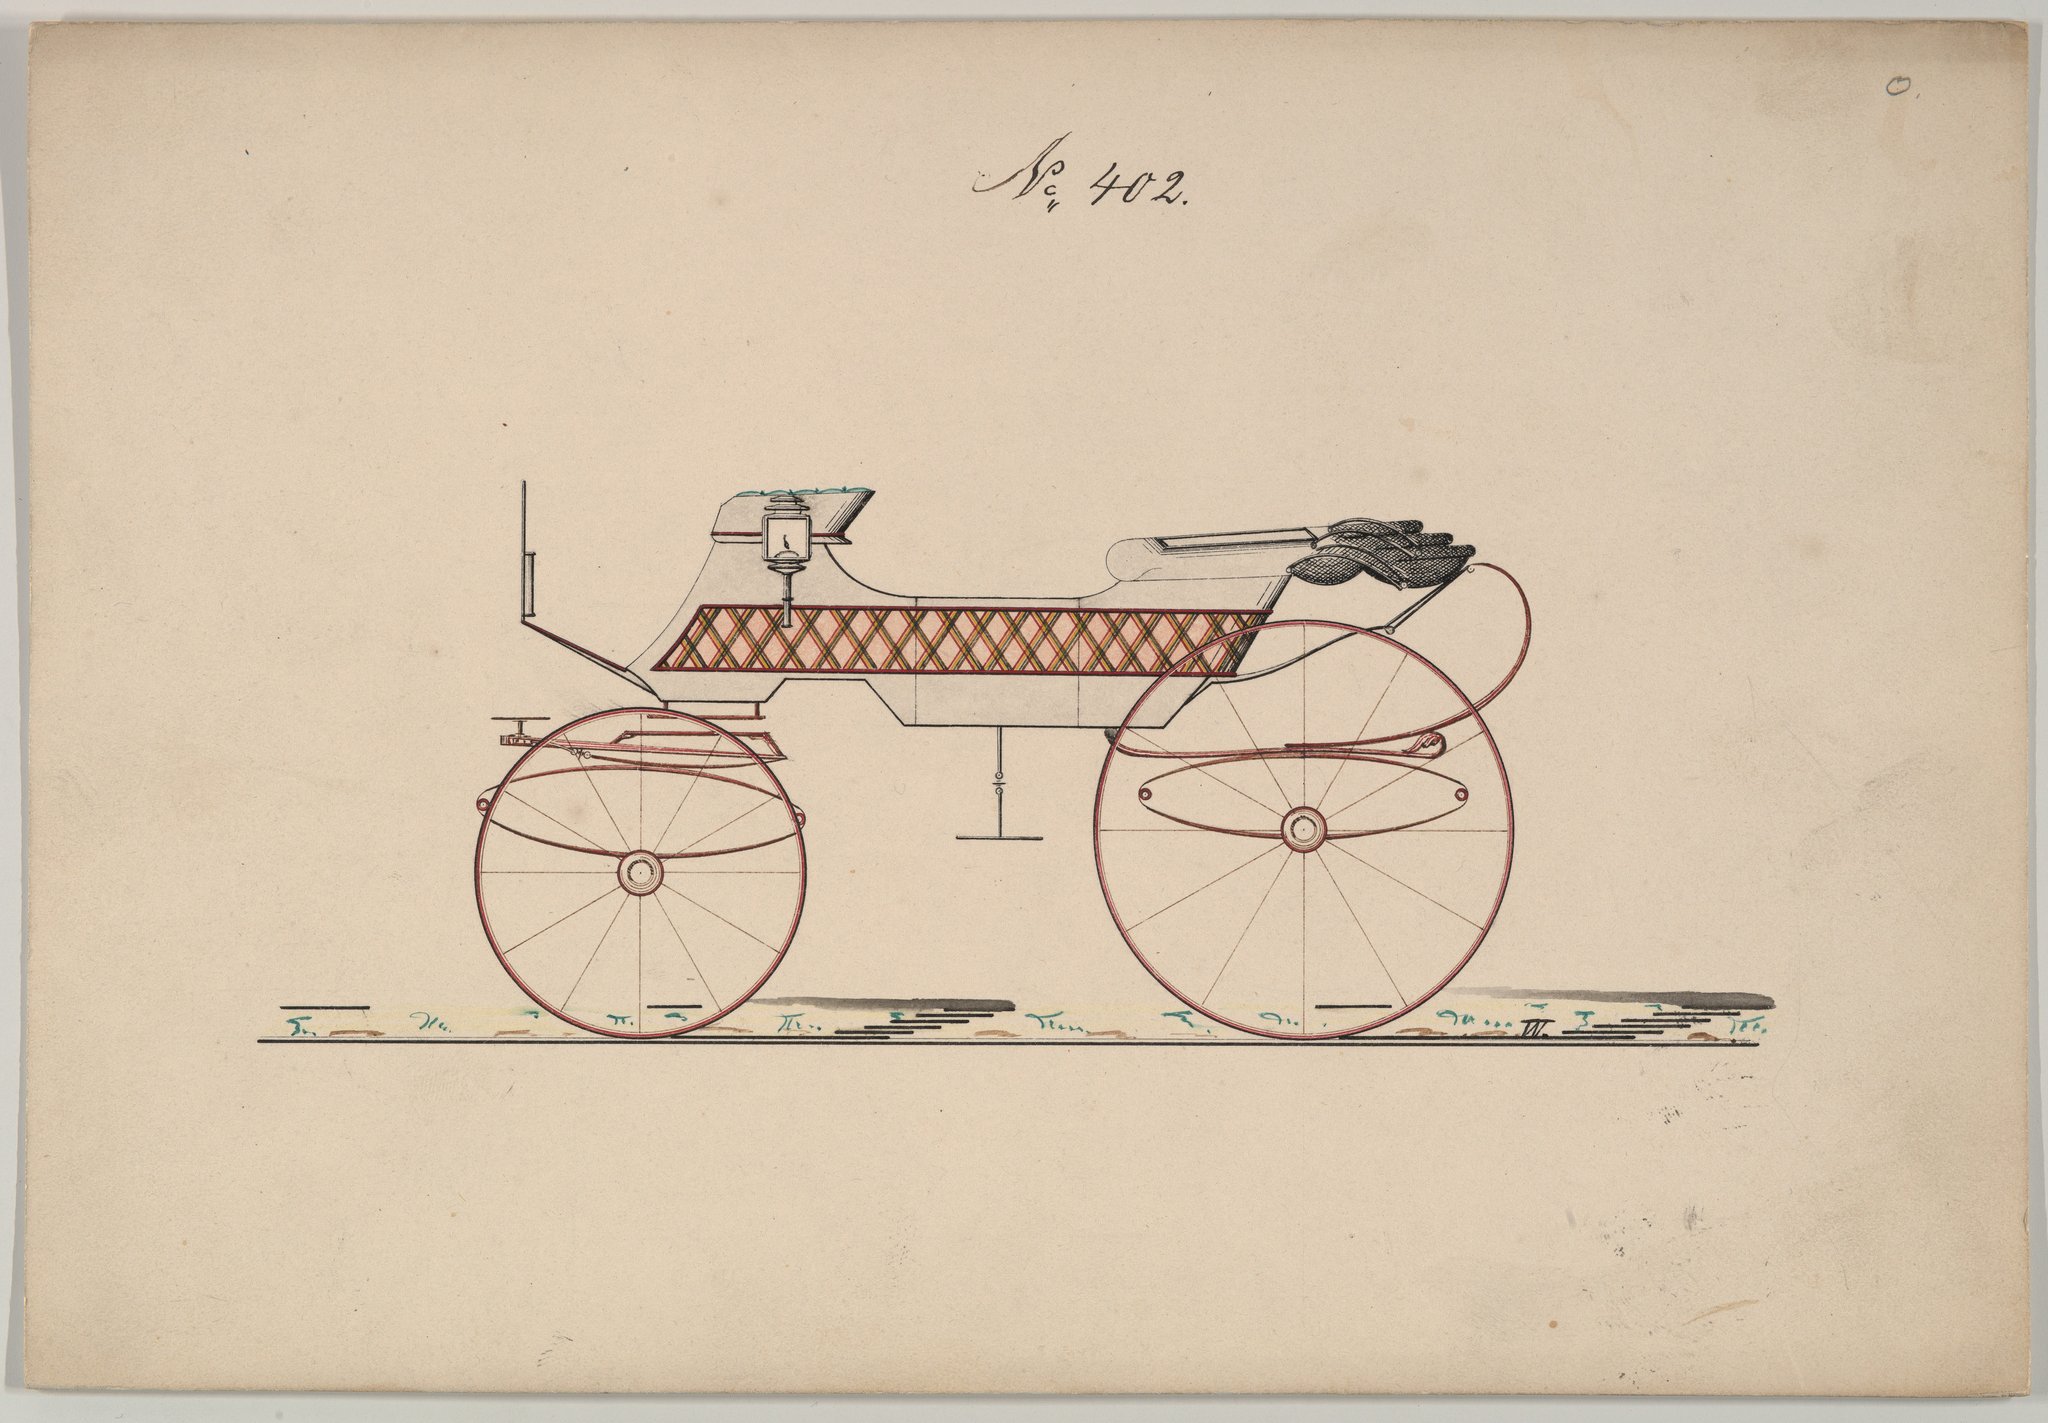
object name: drawing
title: Design for Two Seat Phaeton, no. 402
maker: brewster & co.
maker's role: manufacturer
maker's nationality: american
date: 1850-1874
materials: gouache, ink, watercolor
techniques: pen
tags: carriages